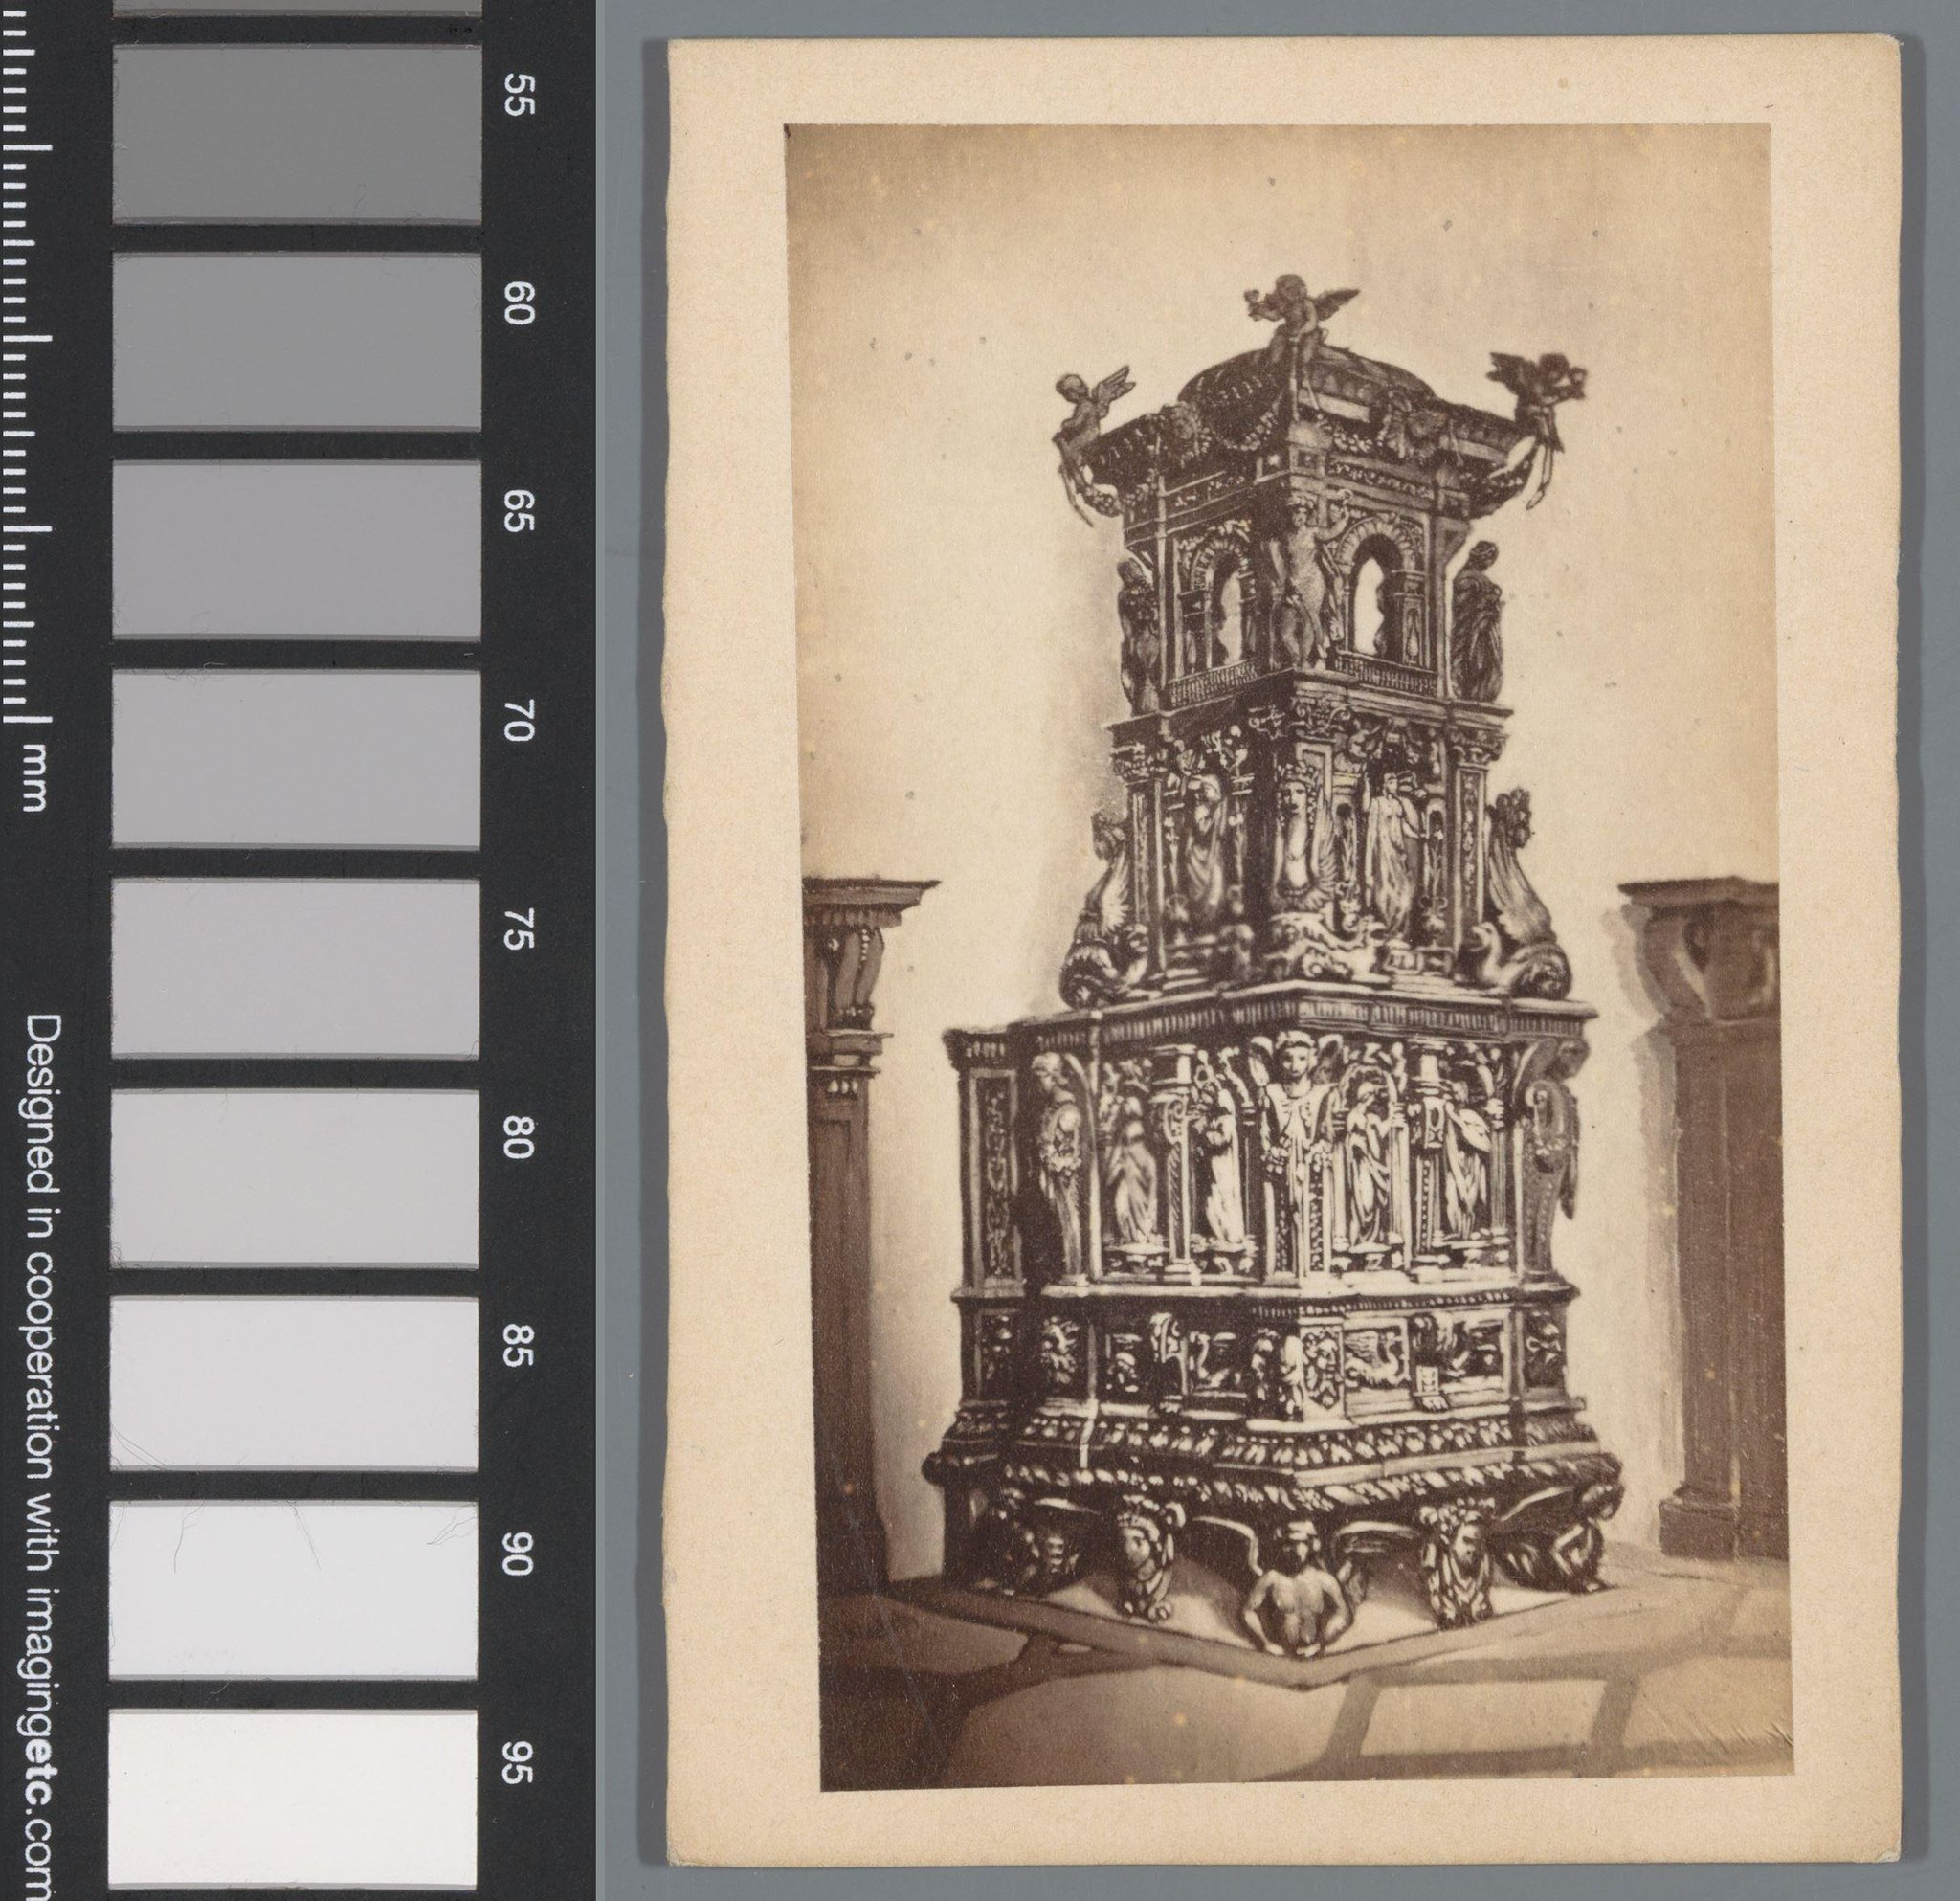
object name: carte de visite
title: Fotoreproductie van een prent waarop een reliekhouder is afgebeeld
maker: ferdinand brauer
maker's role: publisher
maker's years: -1915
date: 1855-1885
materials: cardboard, paper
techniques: albumen print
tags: relics (and reliquaries)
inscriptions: inscription: ‘[...]’